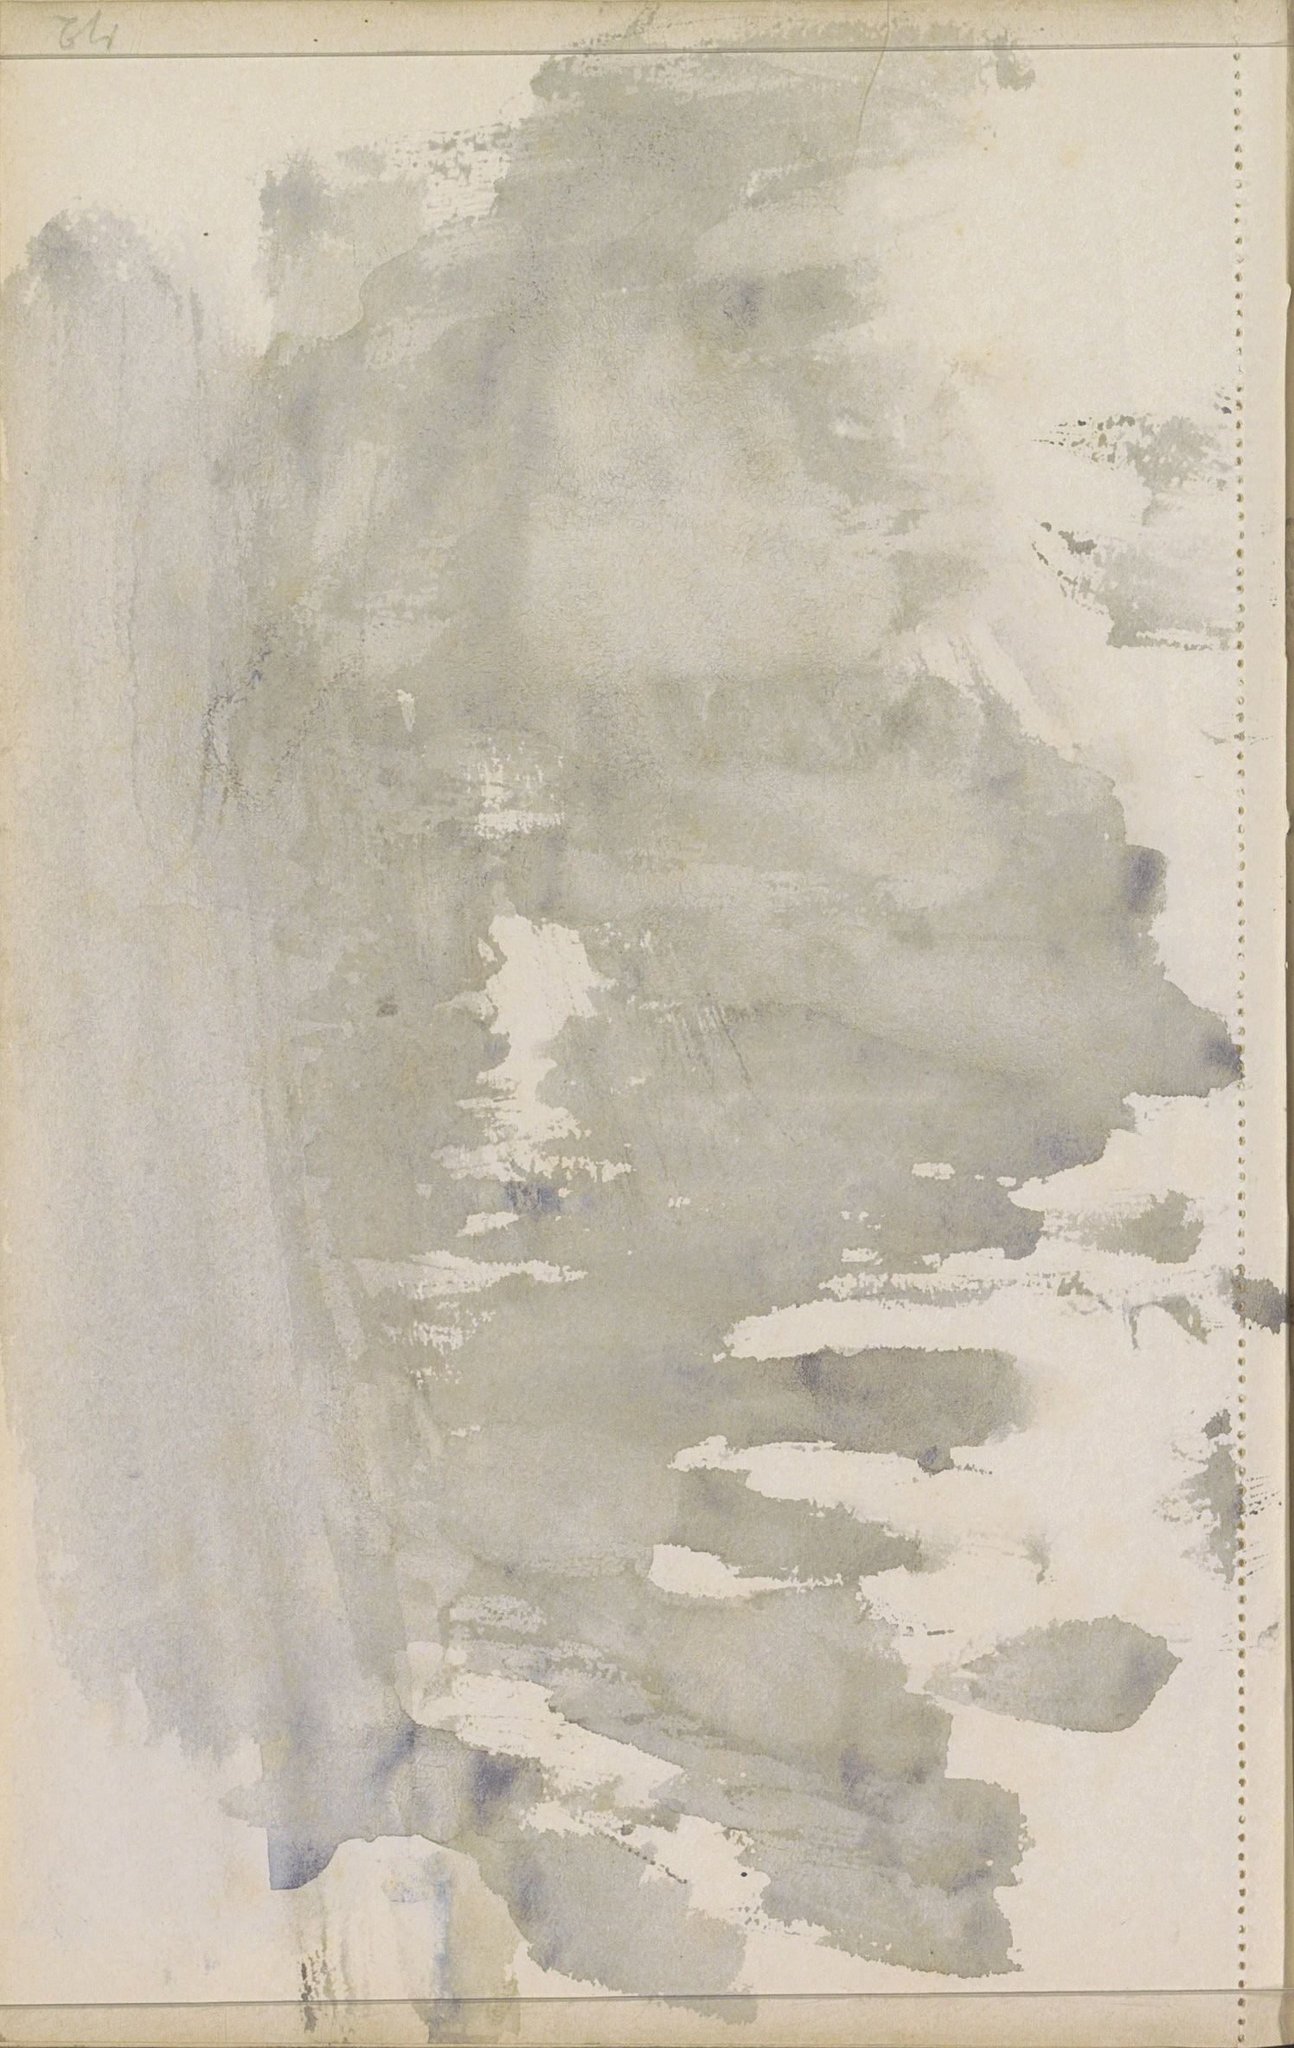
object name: sketchbook leaf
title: Studie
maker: isaac israels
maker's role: draughtsman, painter, print maker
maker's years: 1865-1934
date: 1875-1934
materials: paper, watercolor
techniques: brush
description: Blad 15 verso uit schetsboek LII met 43 bladen.